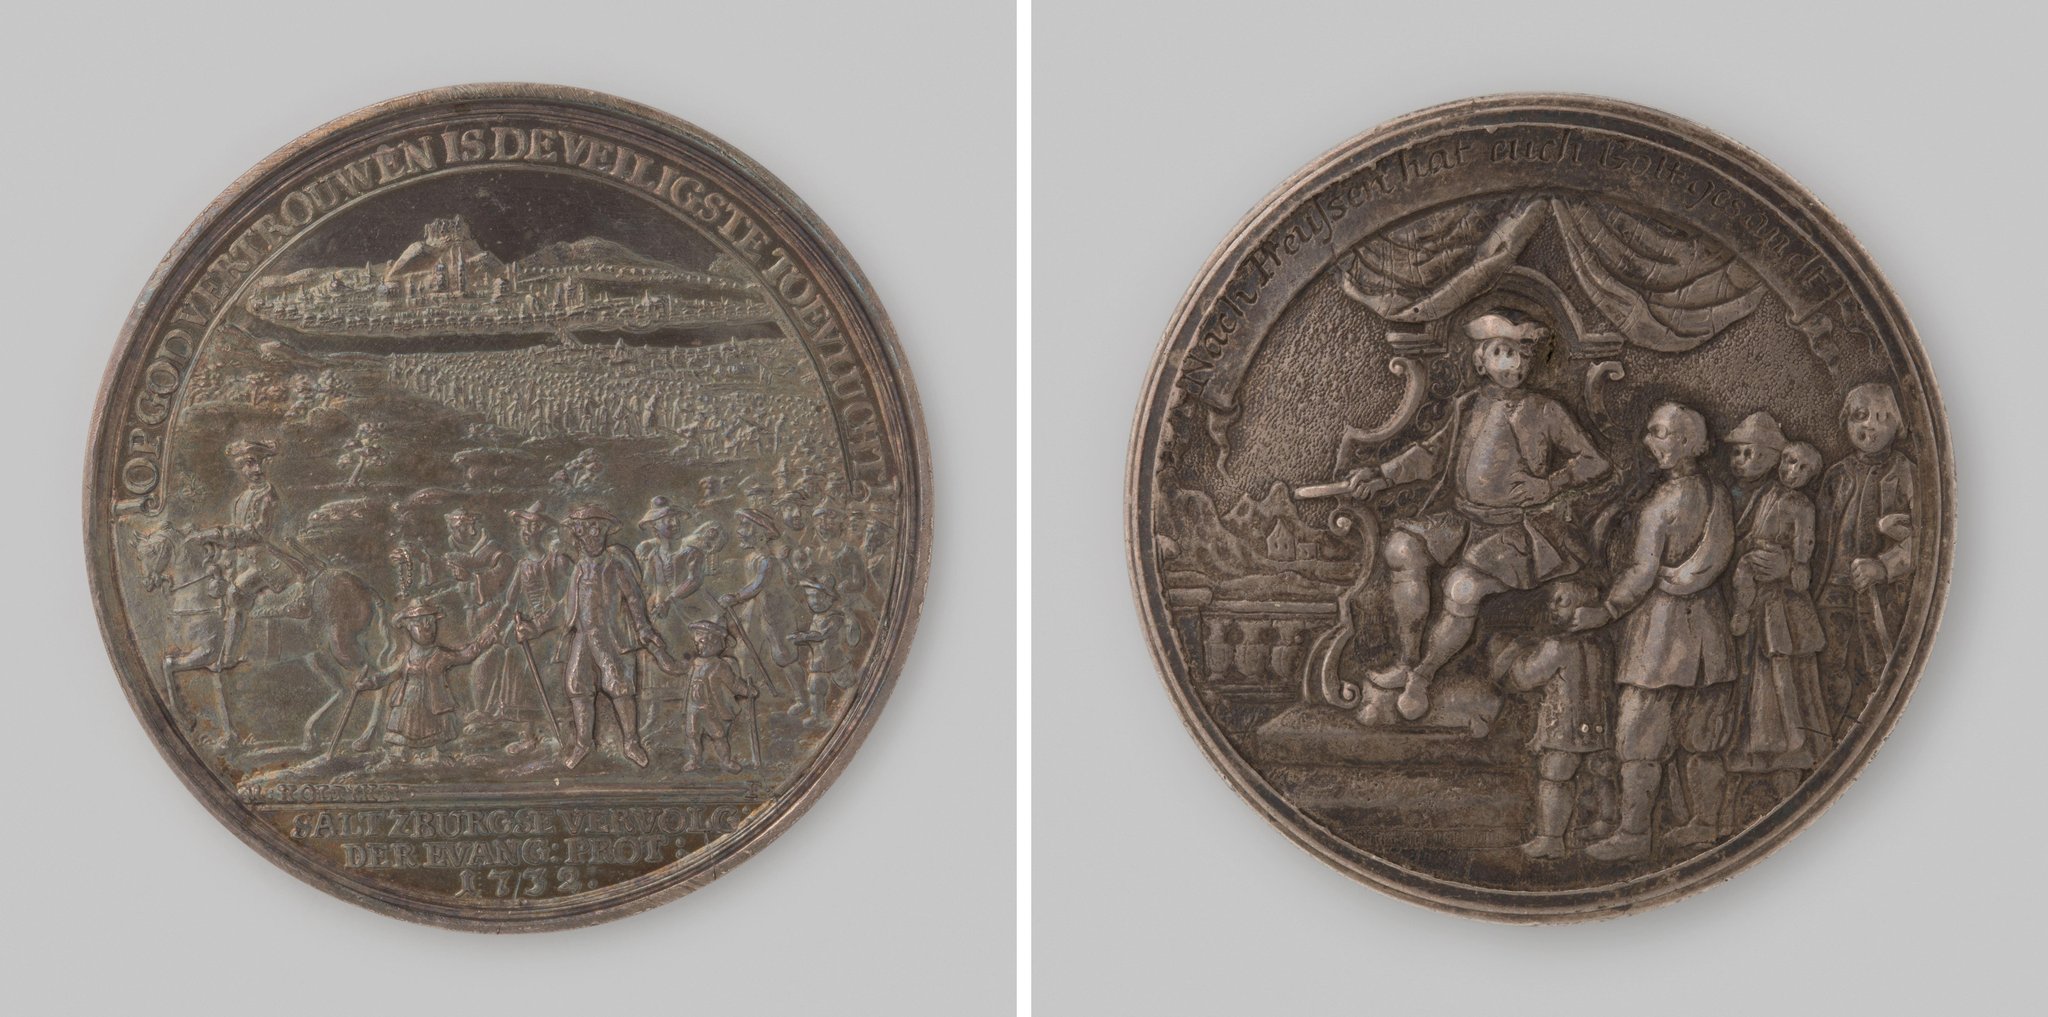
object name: history medal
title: Uittocht der Salzburger Emigranten 1732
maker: martinus holtzhey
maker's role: medailleur, muntmaker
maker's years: 1697-1764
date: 1732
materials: silver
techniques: striking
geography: amsterdam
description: Zilveren penning, op de voorzijde een groep landverhuizers die Saltzburg verlaat, met omschrift en afsnedetekst, op de keerzijde dertien regels tekst.